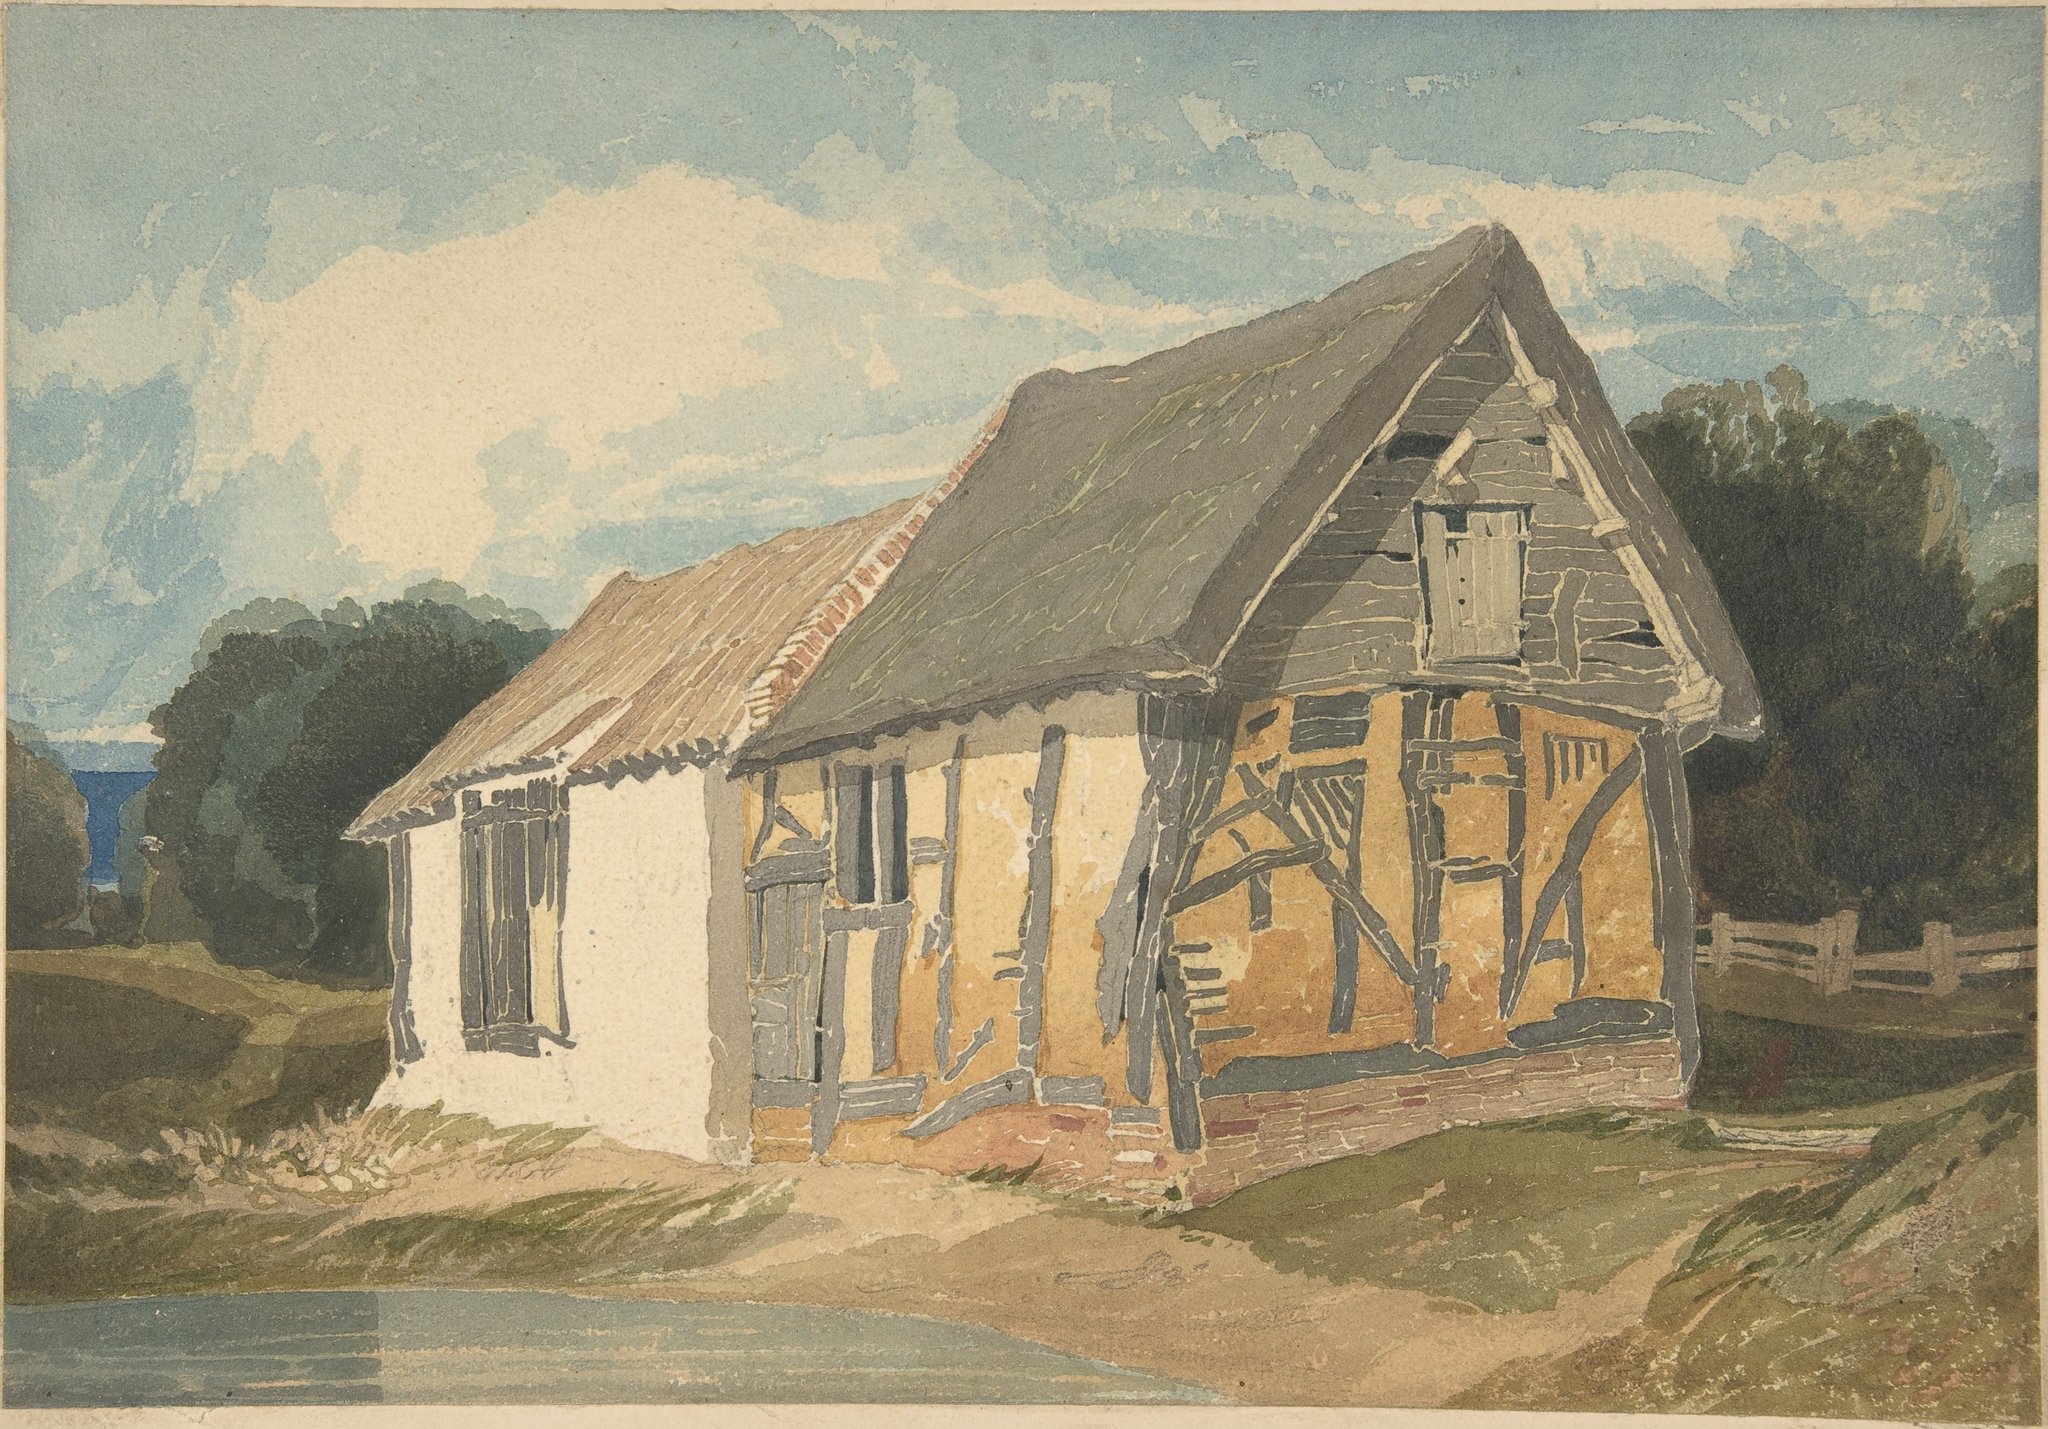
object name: drawing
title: Farm Building by a Pond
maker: john sell cotman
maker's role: artist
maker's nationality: british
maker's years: 1782-1842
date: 1808-1811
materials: graphite, watercolor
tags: buildings